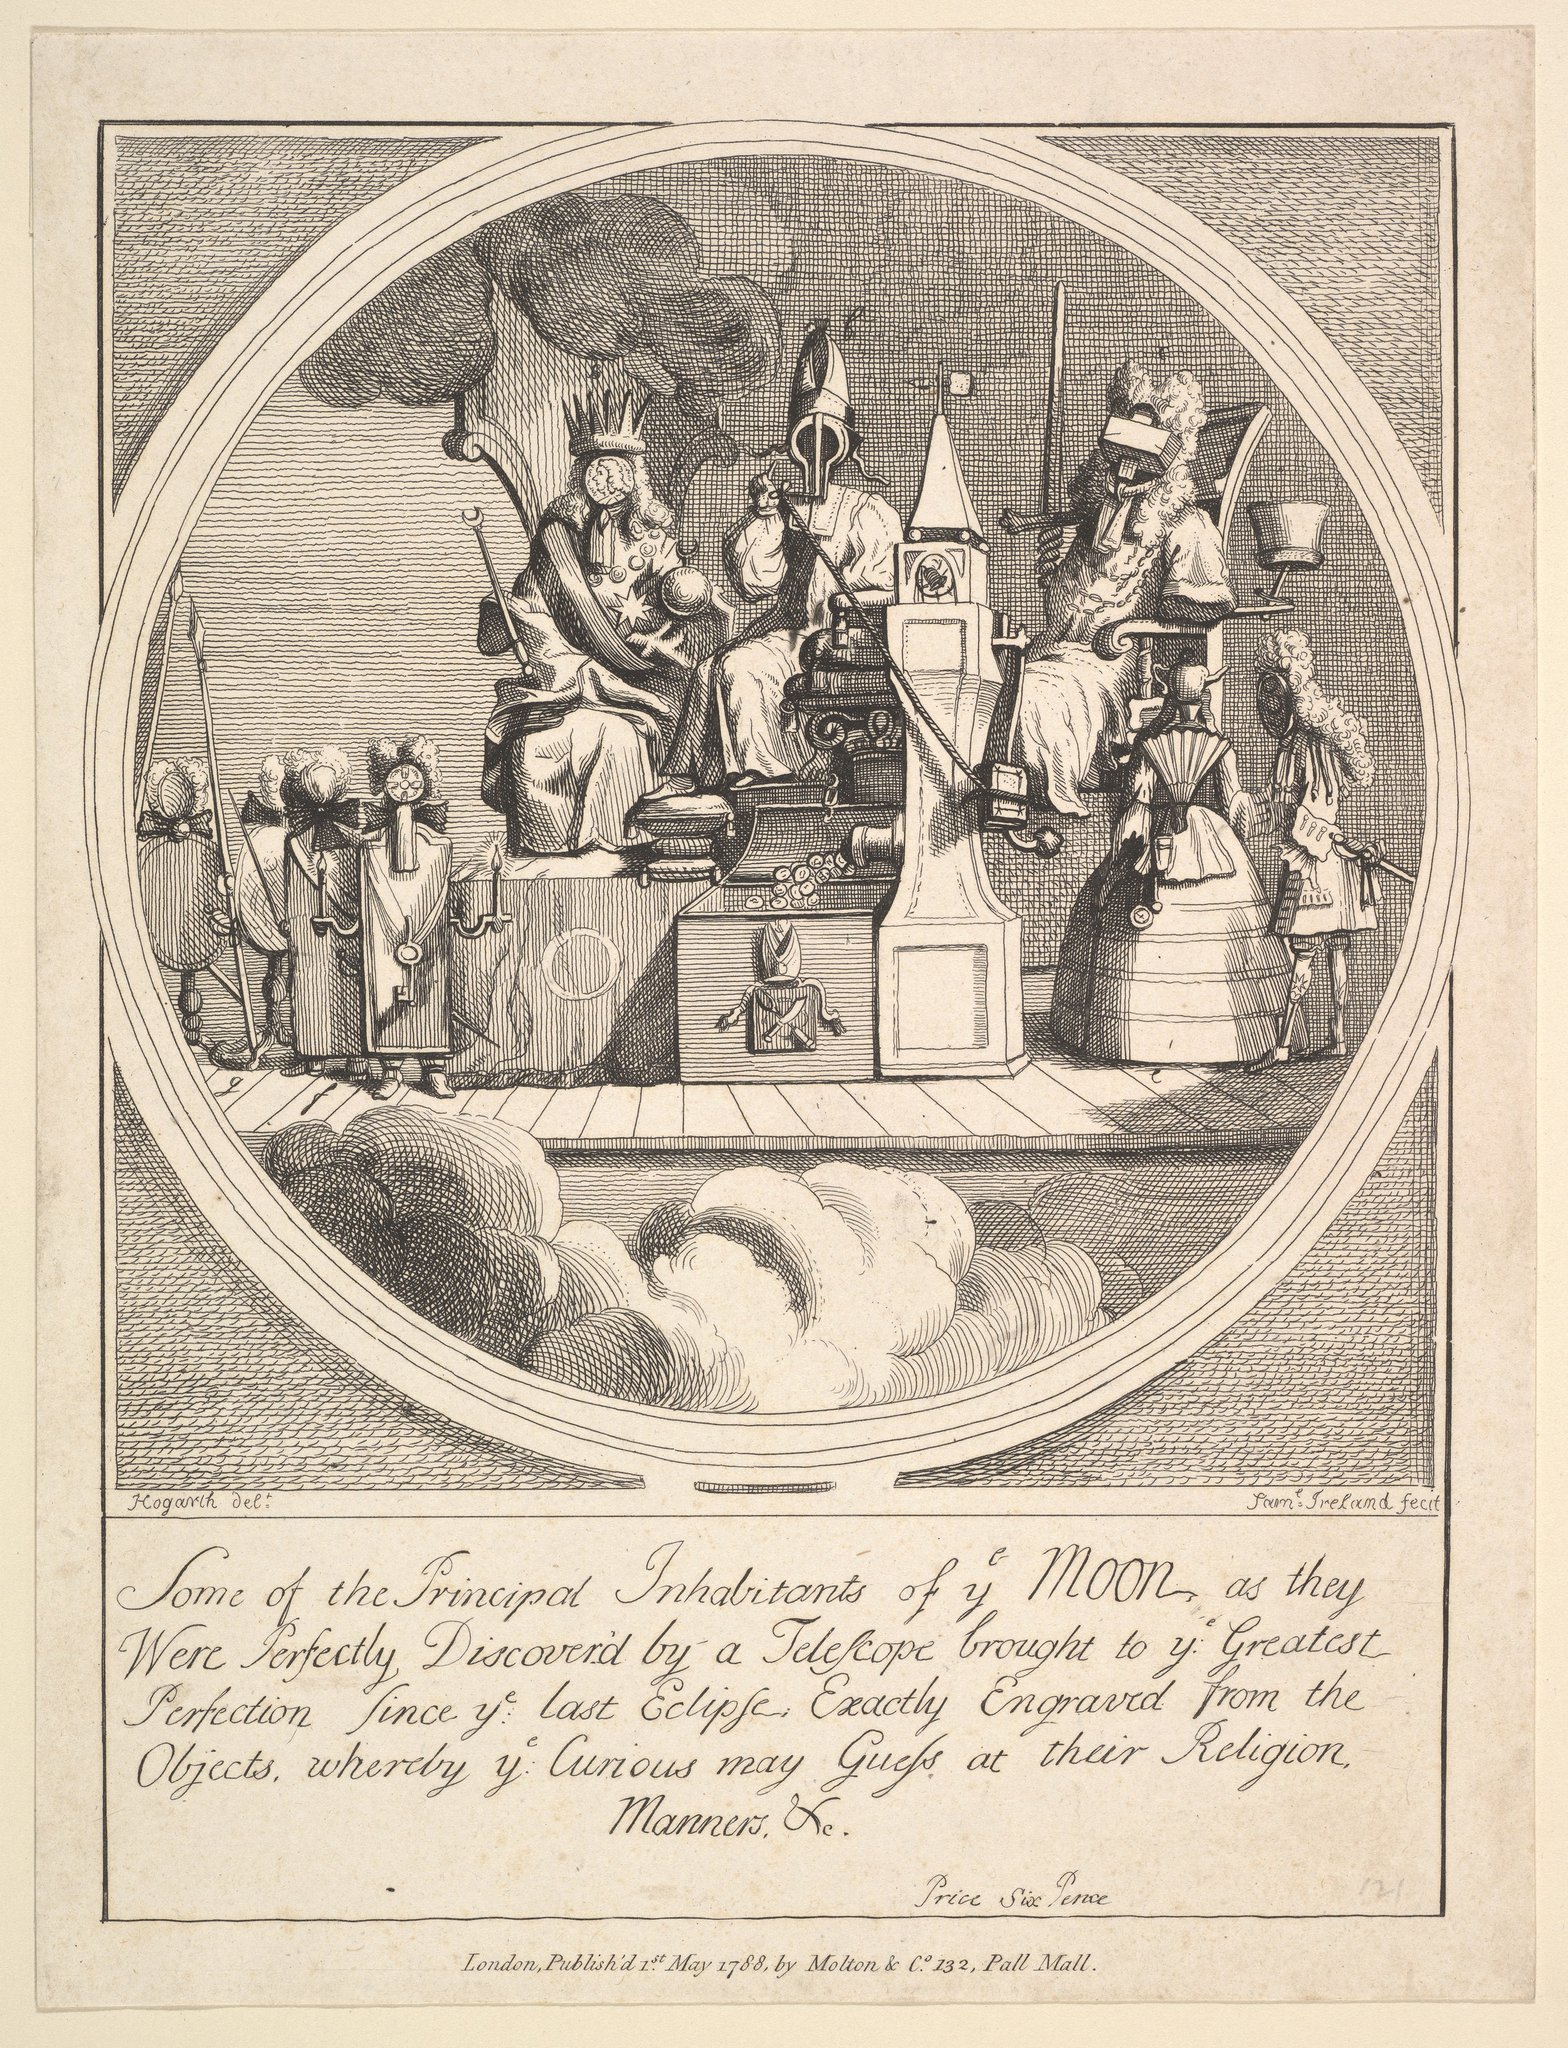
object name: print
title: Some of the Principal Inhabitants of the Moon, as They Were Perfectly Discovered by a Telescope...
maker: samuel ireland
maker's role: engraver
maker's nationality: british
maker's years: 1700-1800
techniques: engraving, etching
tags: men